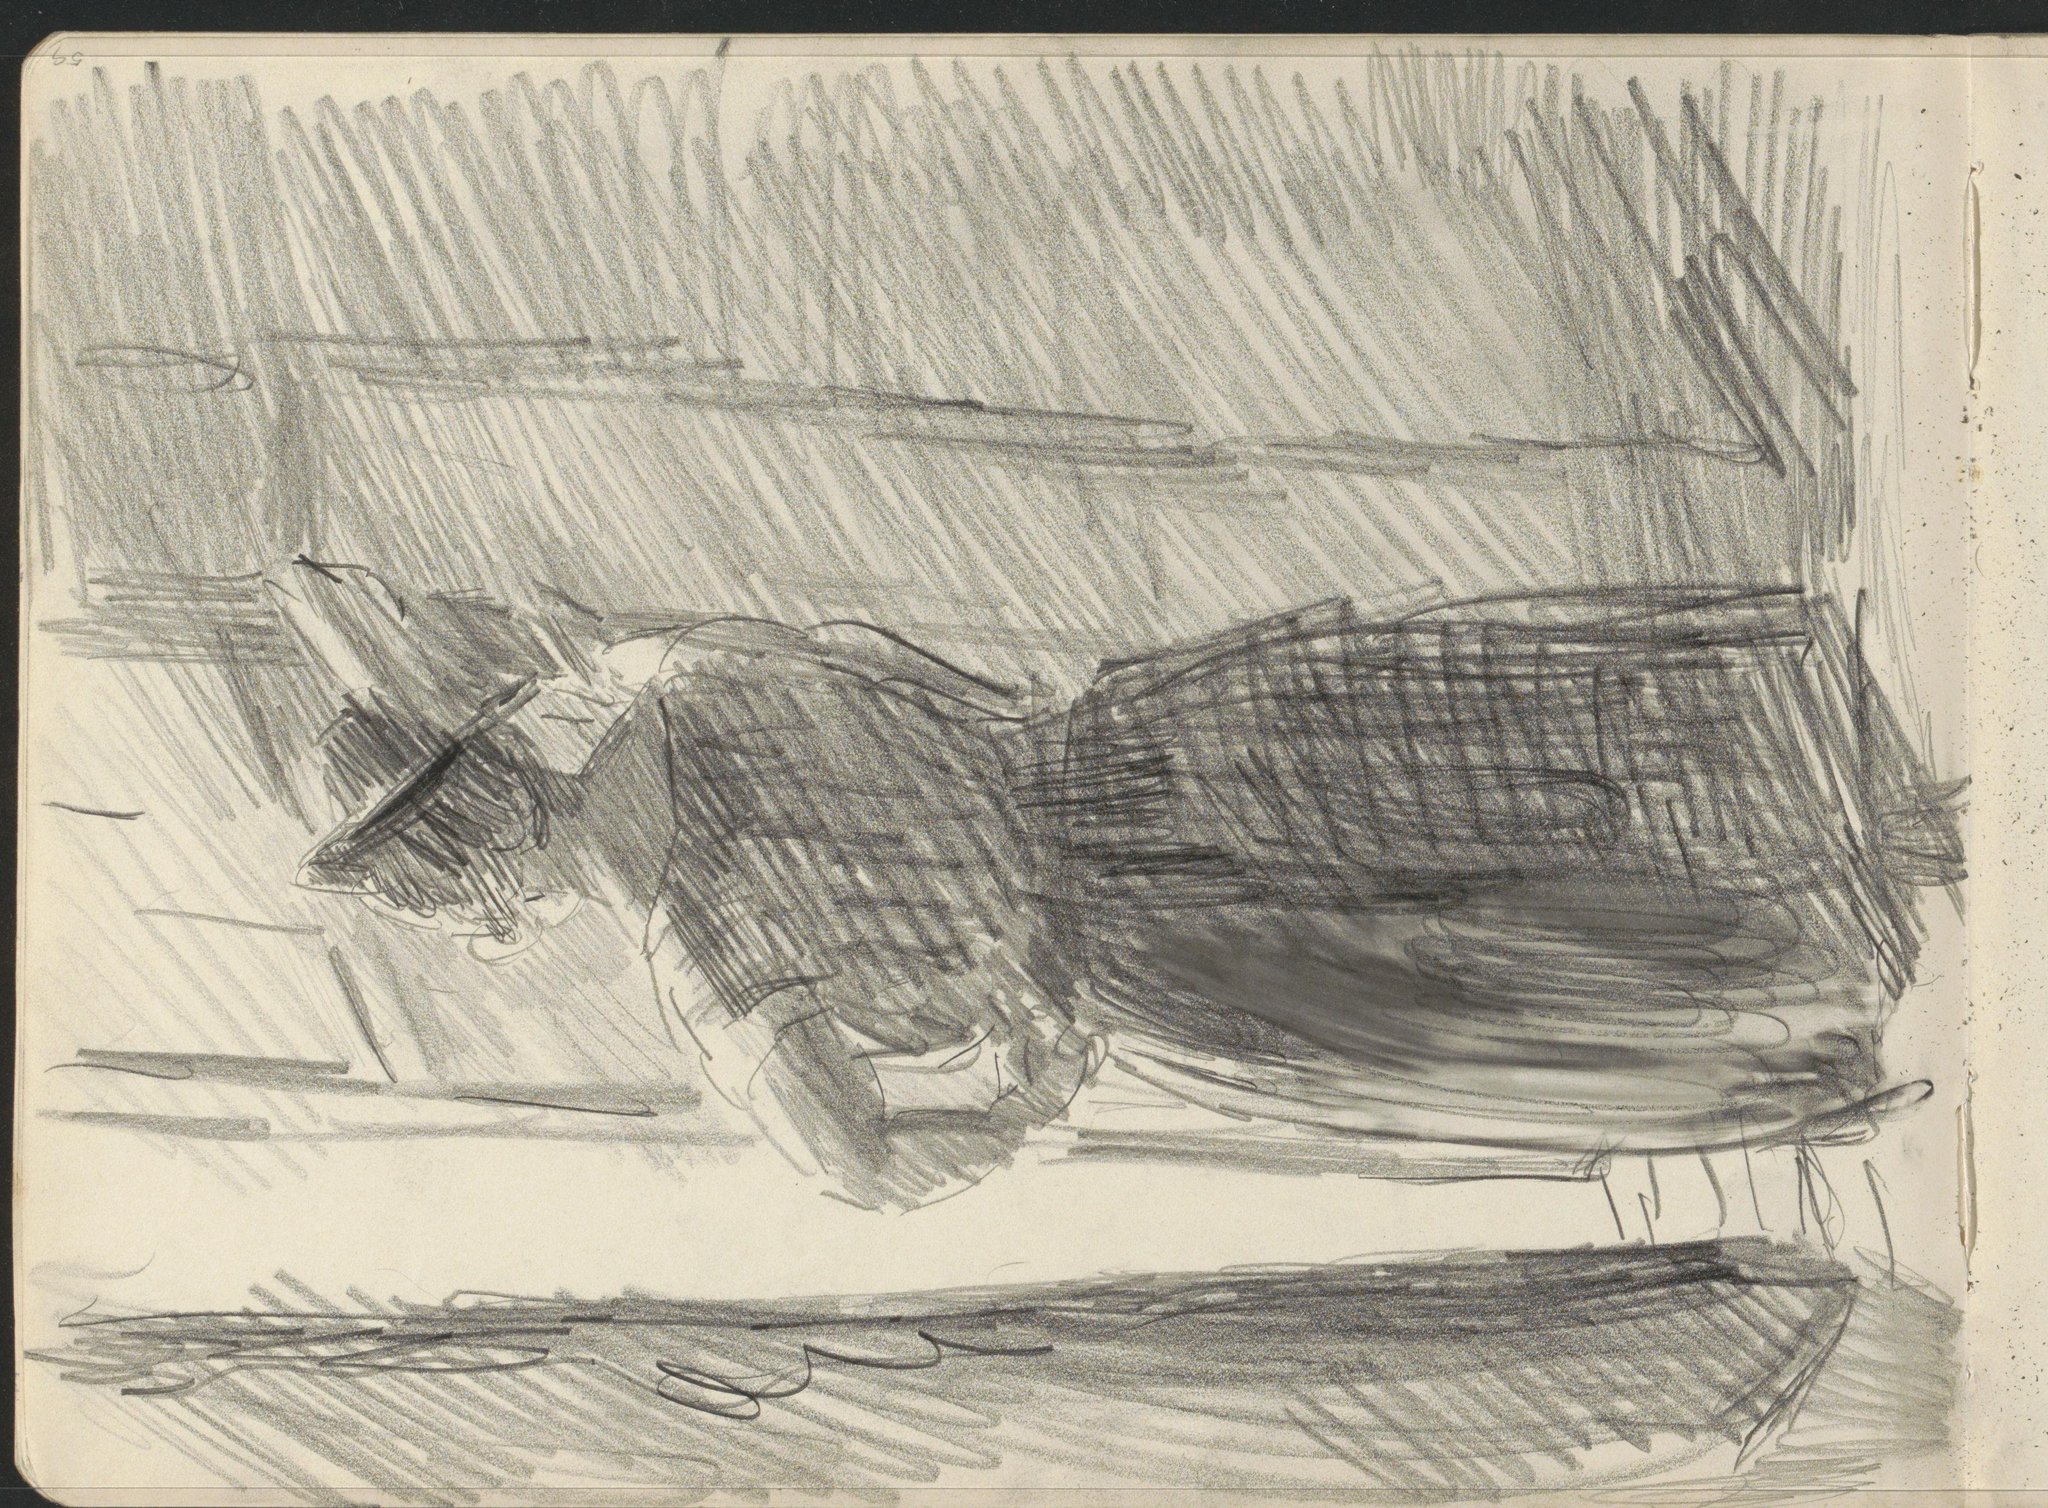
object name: sketchbook leaf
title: Staande vrouw met hoed, op de rug gezien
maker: isaac israels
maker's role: draughtsman, painter, print maker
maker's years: 1865-1934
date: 1915-1934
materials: paper, pencil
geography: the hague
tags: adult woman (+ standing), the stage and its equipment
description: Ze staat mogelijk tussen coulissen. Blad 4 verso uit schetsboek XVII met 31 bladen.